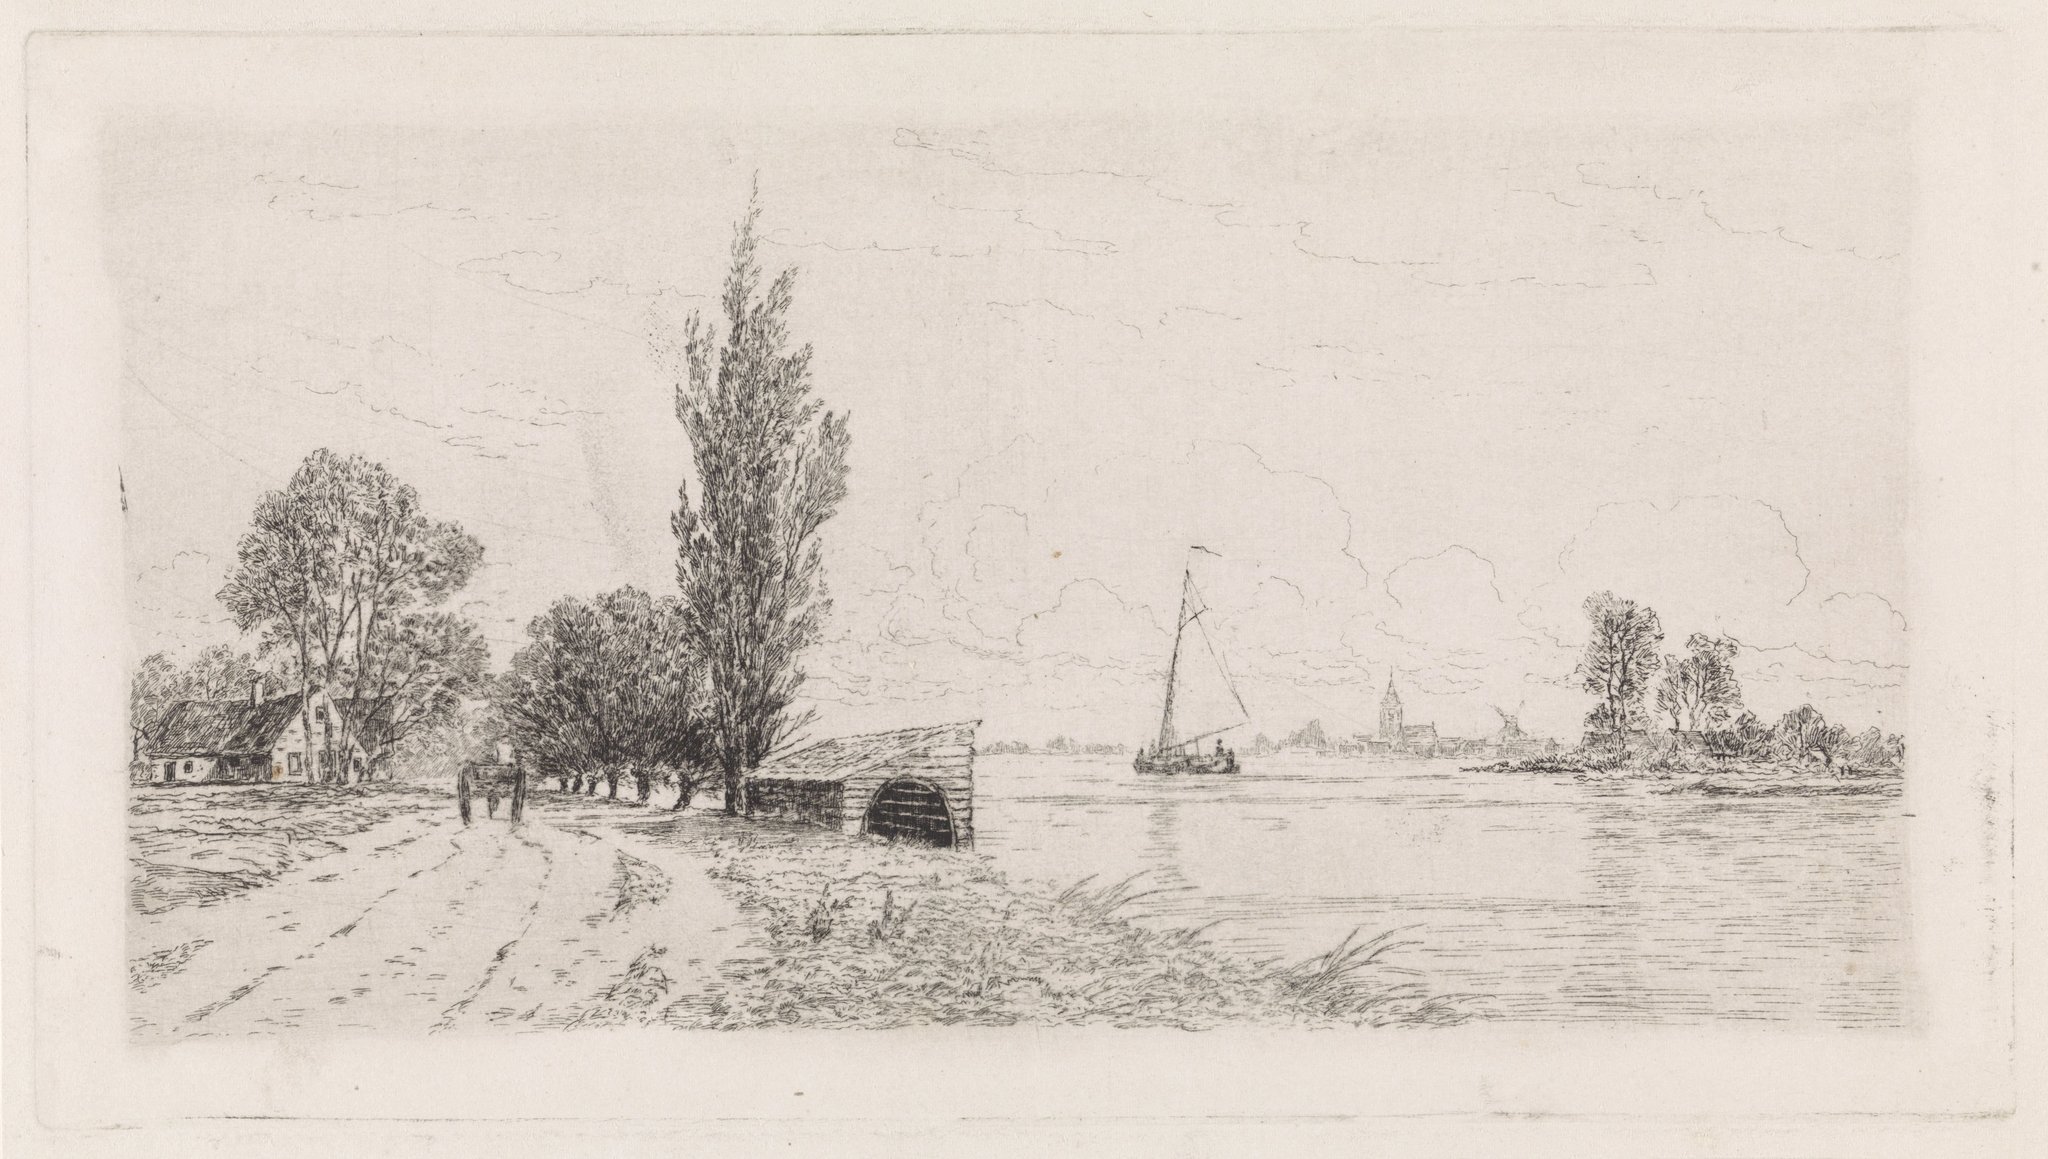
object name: print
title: Rivierlandschap met zeilschip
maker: elias stark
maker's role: draughtsman, print maker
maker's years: 1849-1933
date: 1889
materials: paper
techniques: etching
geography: nieuwer-amstel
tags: sailing-ship, sailing-boat, river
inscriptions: collector's mark: Lugt 2228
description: Landschap met op de rivier een zeilschip en op de achtergrond een dorp. Links langs het water een weg waarop een wagen rijdt.